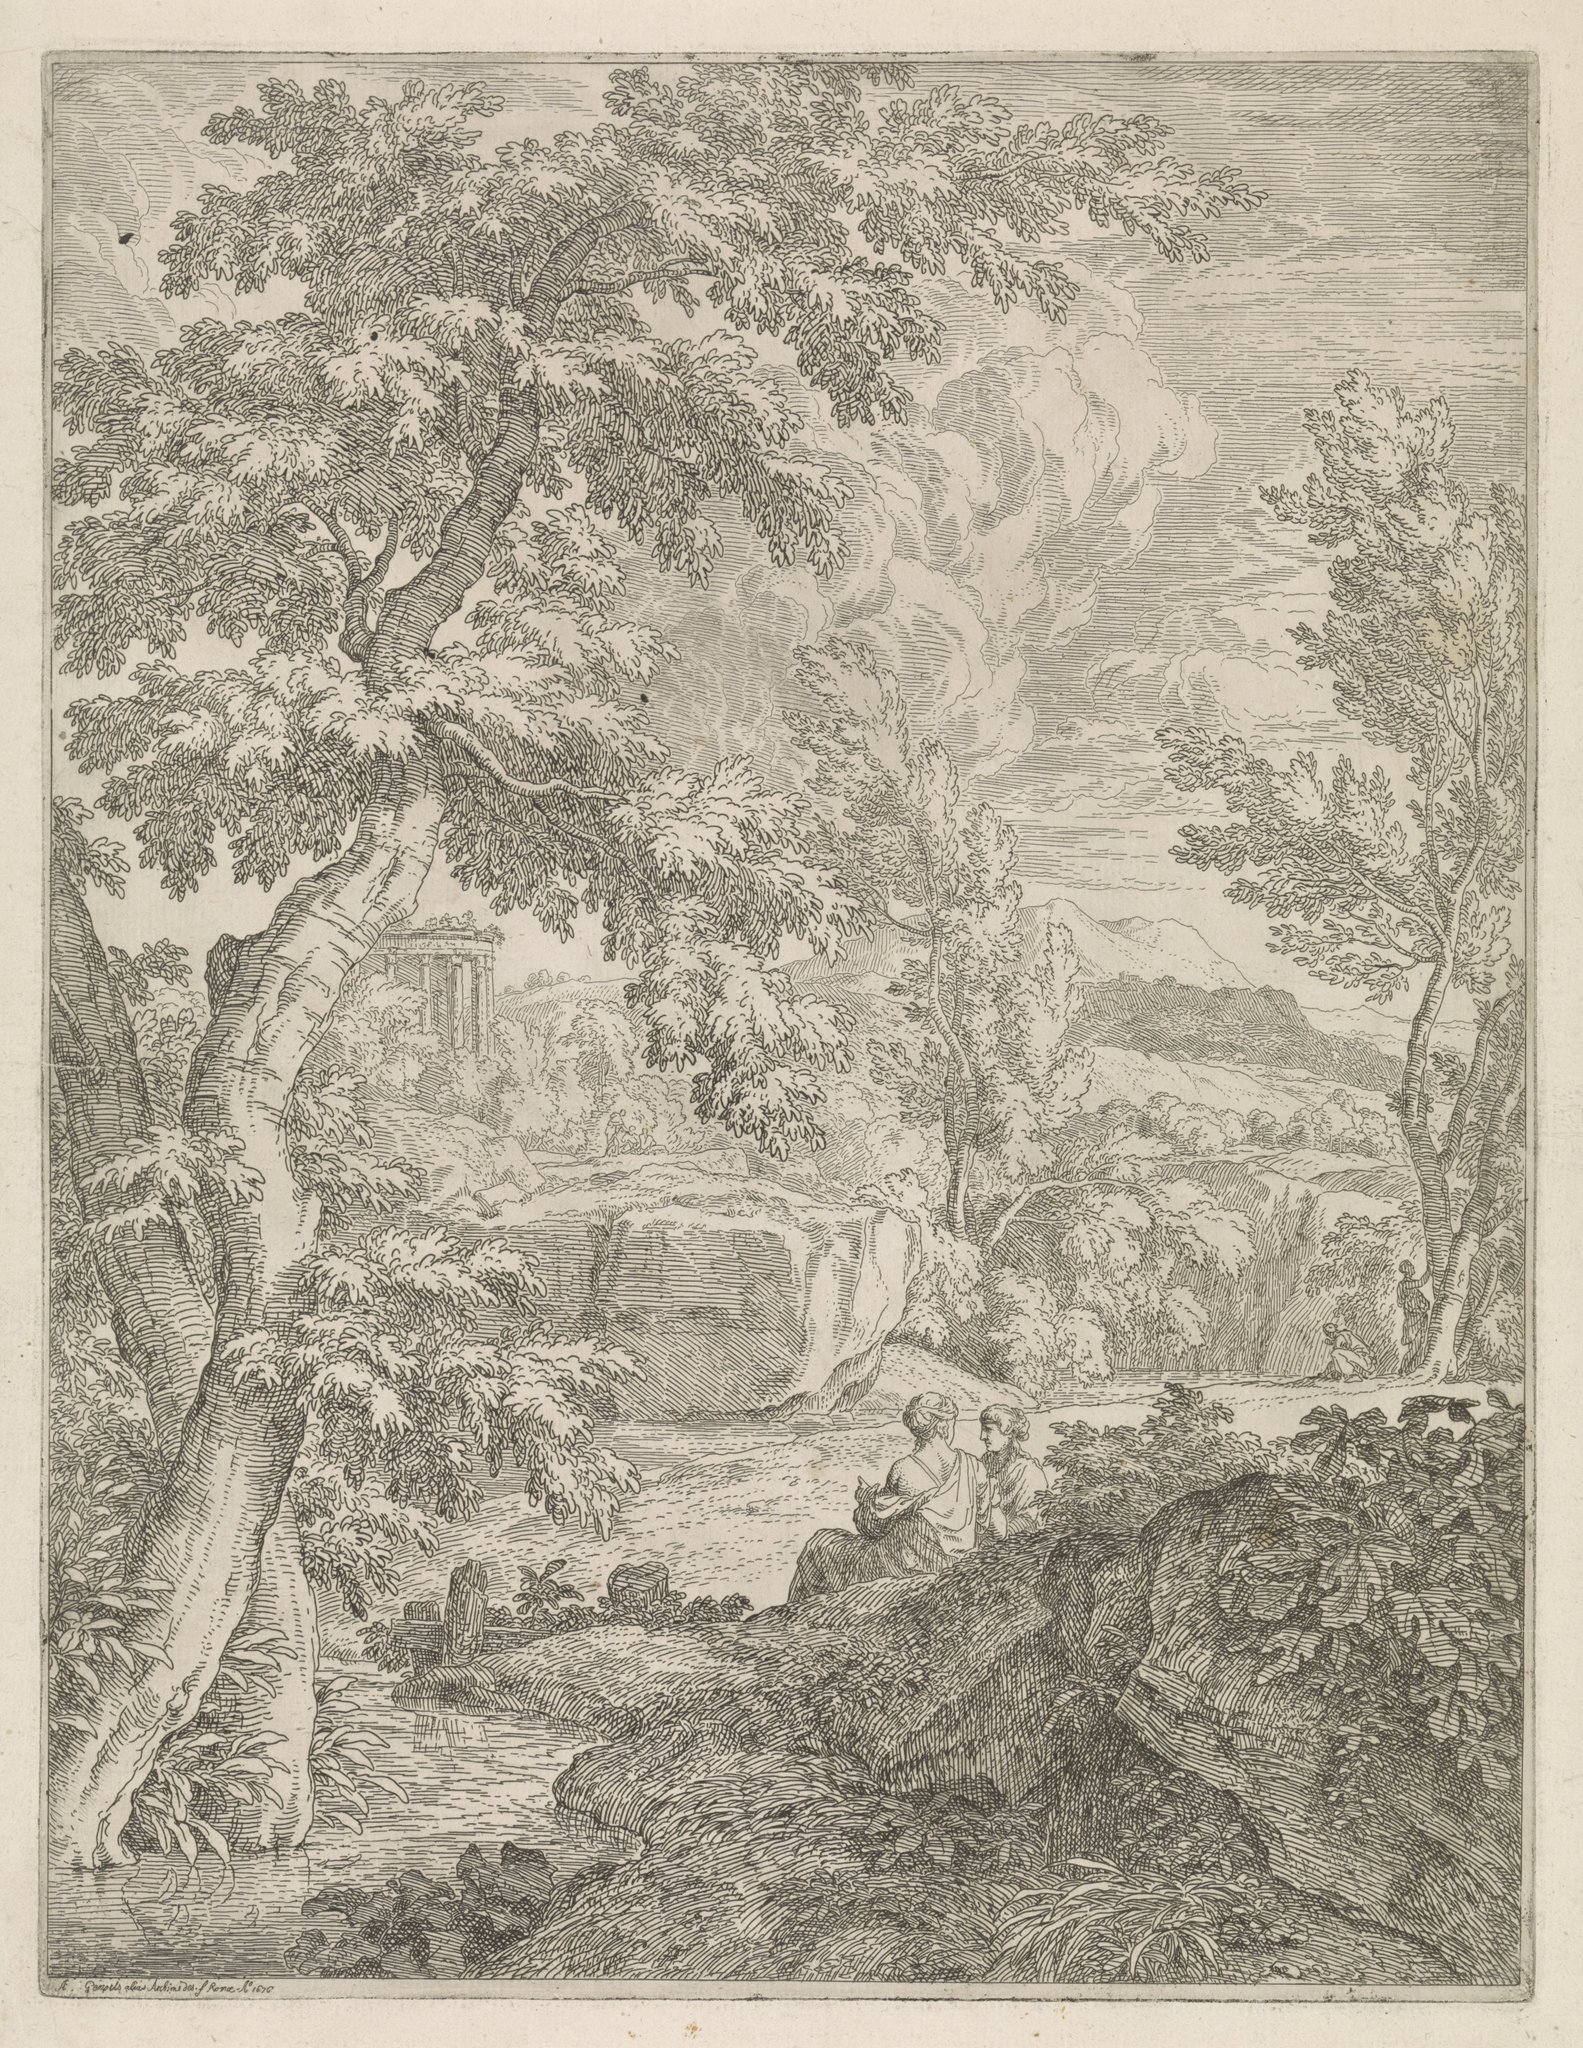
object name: print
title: Landschap met rivier en een klassieke ruïne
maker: abraham genoels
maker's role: draughtsman, print maker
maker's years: 1640-1723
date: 1676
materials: paper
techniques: etching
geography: rome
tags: temple, shrine ~ roman religion, river (+ landscape with figures, staffage), landscape with ruins (+ city(-scape) with figures, staffage)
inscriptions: collector's mark: Lugt 240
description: Twee vrouwen zitten aan de oever van een rivier. Op de achtergrond de ruïne van een klassieke tempel.